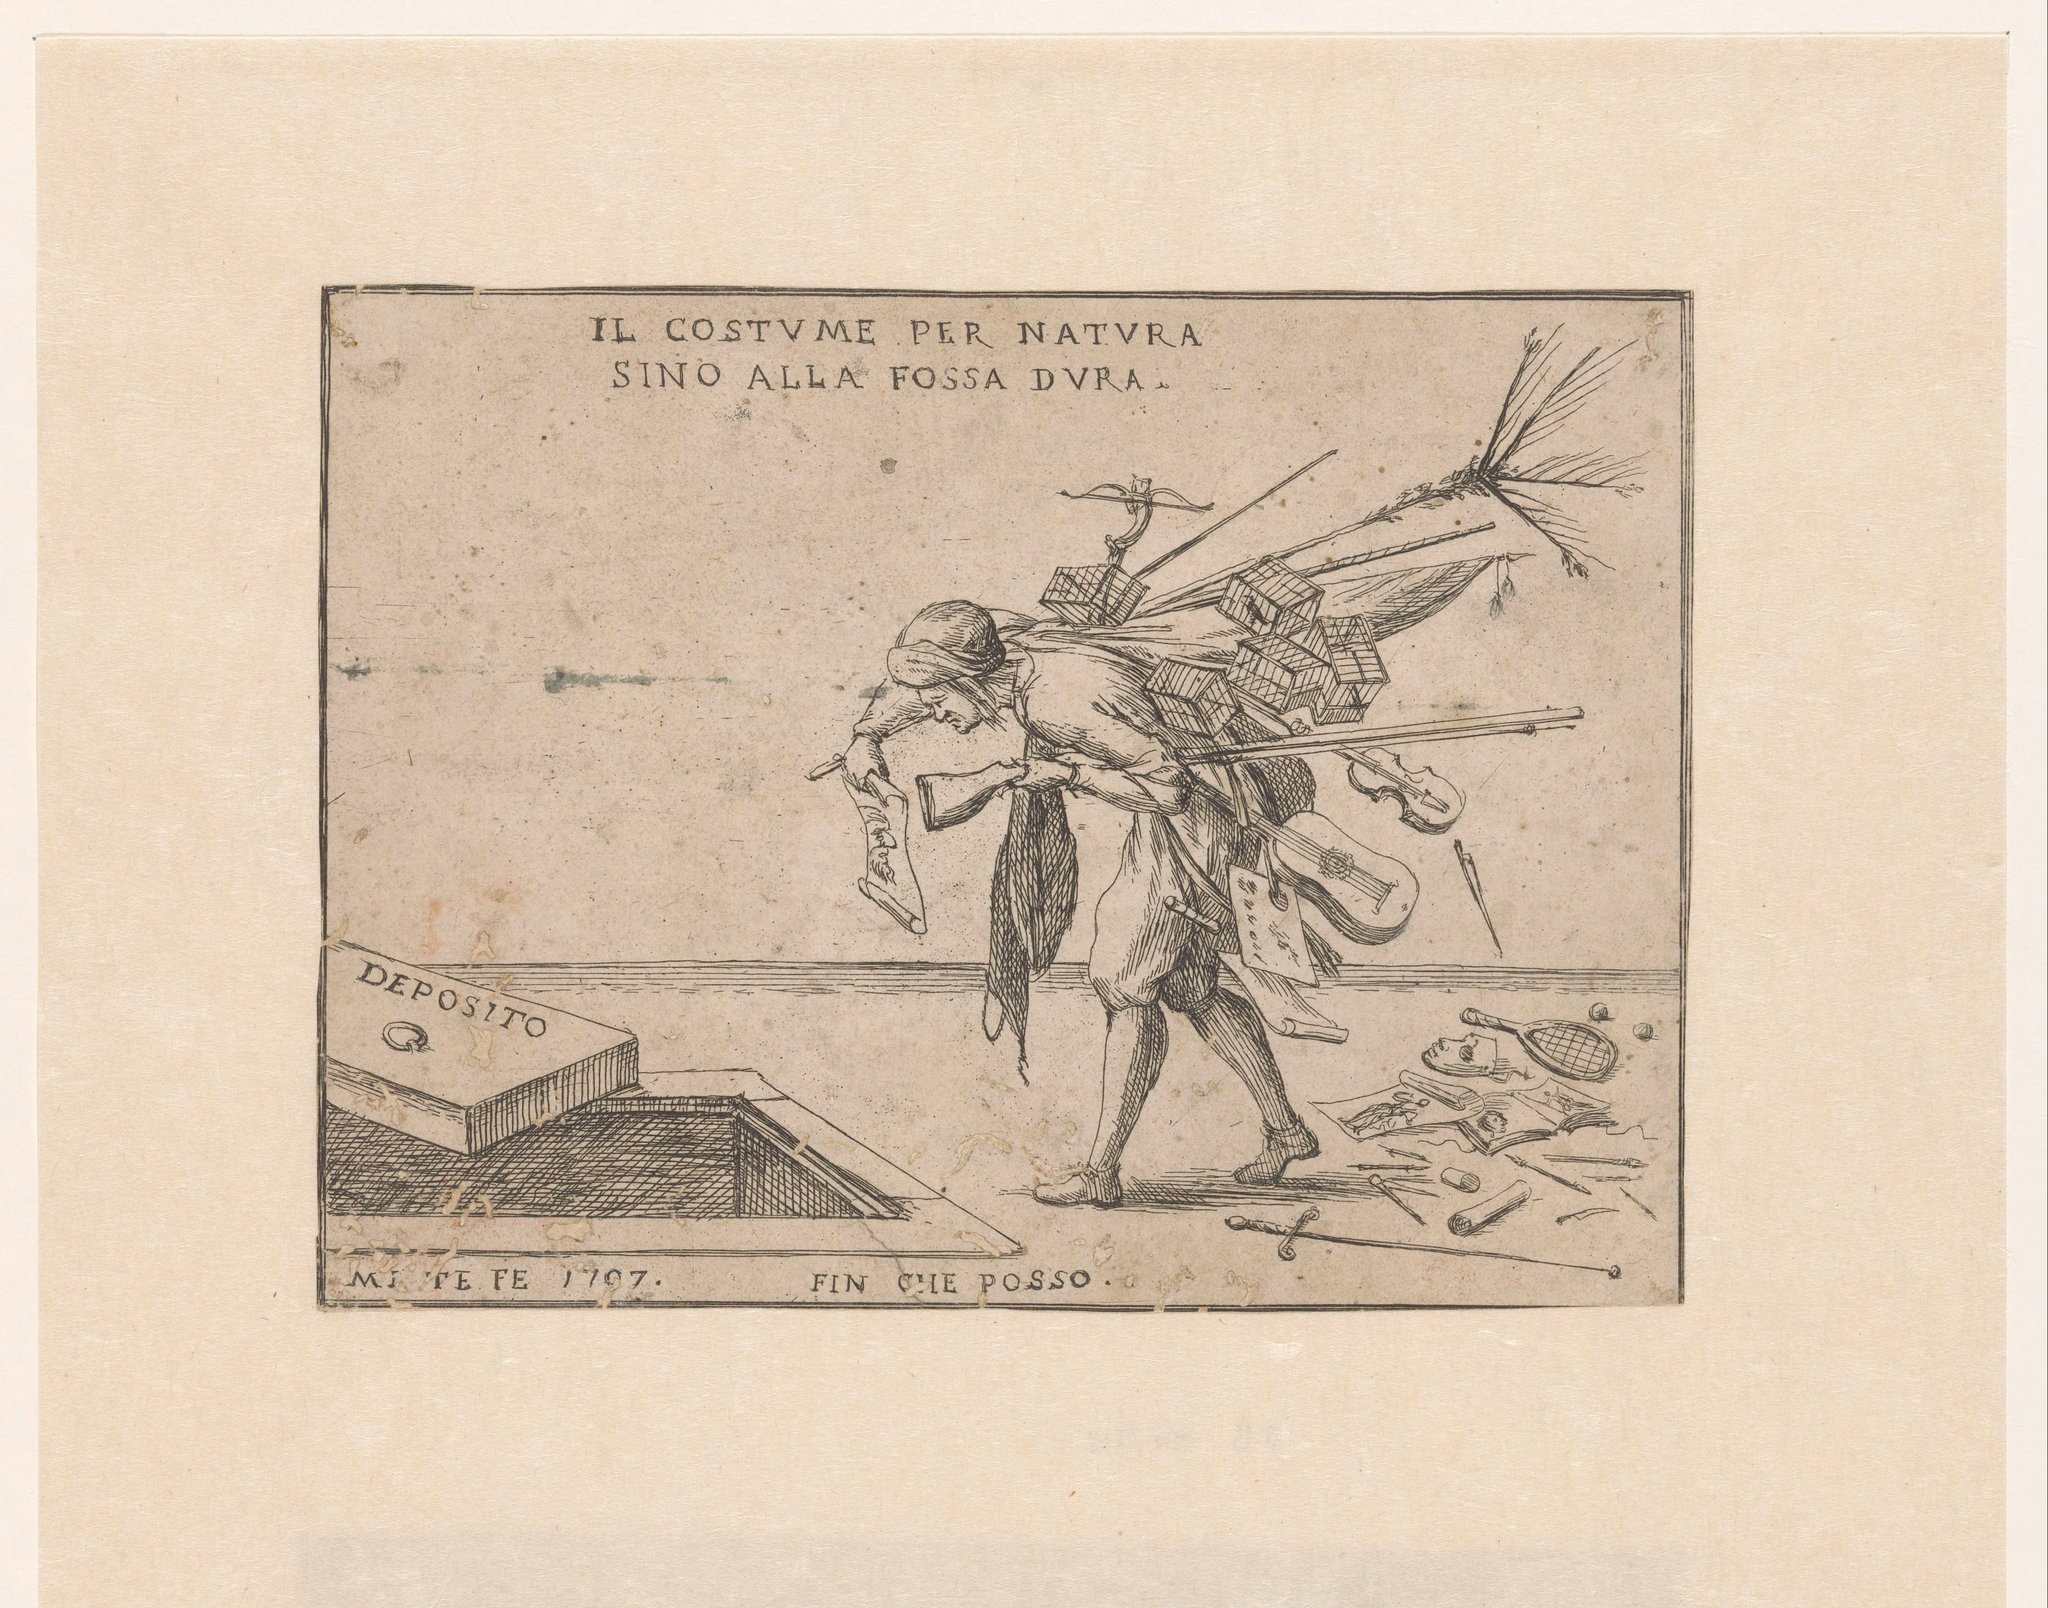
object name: print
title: Il costume per natura sino alla fossa dura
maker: giuseppe maria mitelli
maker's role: draughtsman, painter, print maker, publisher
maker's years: 1634-1718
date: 1707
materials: paper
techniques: etching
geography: italy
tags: grave, tomb, street-trader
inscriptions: collector's mark: Lugt 2228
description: Een man, een straatverkoper beladen met muziekinstrumenten en vogelkooitjes, staand bij een open graf. Een titel in het Italiaans boven de voorstelling. De voorstelling is een allegorie op de menselijke passies en gewoontes.